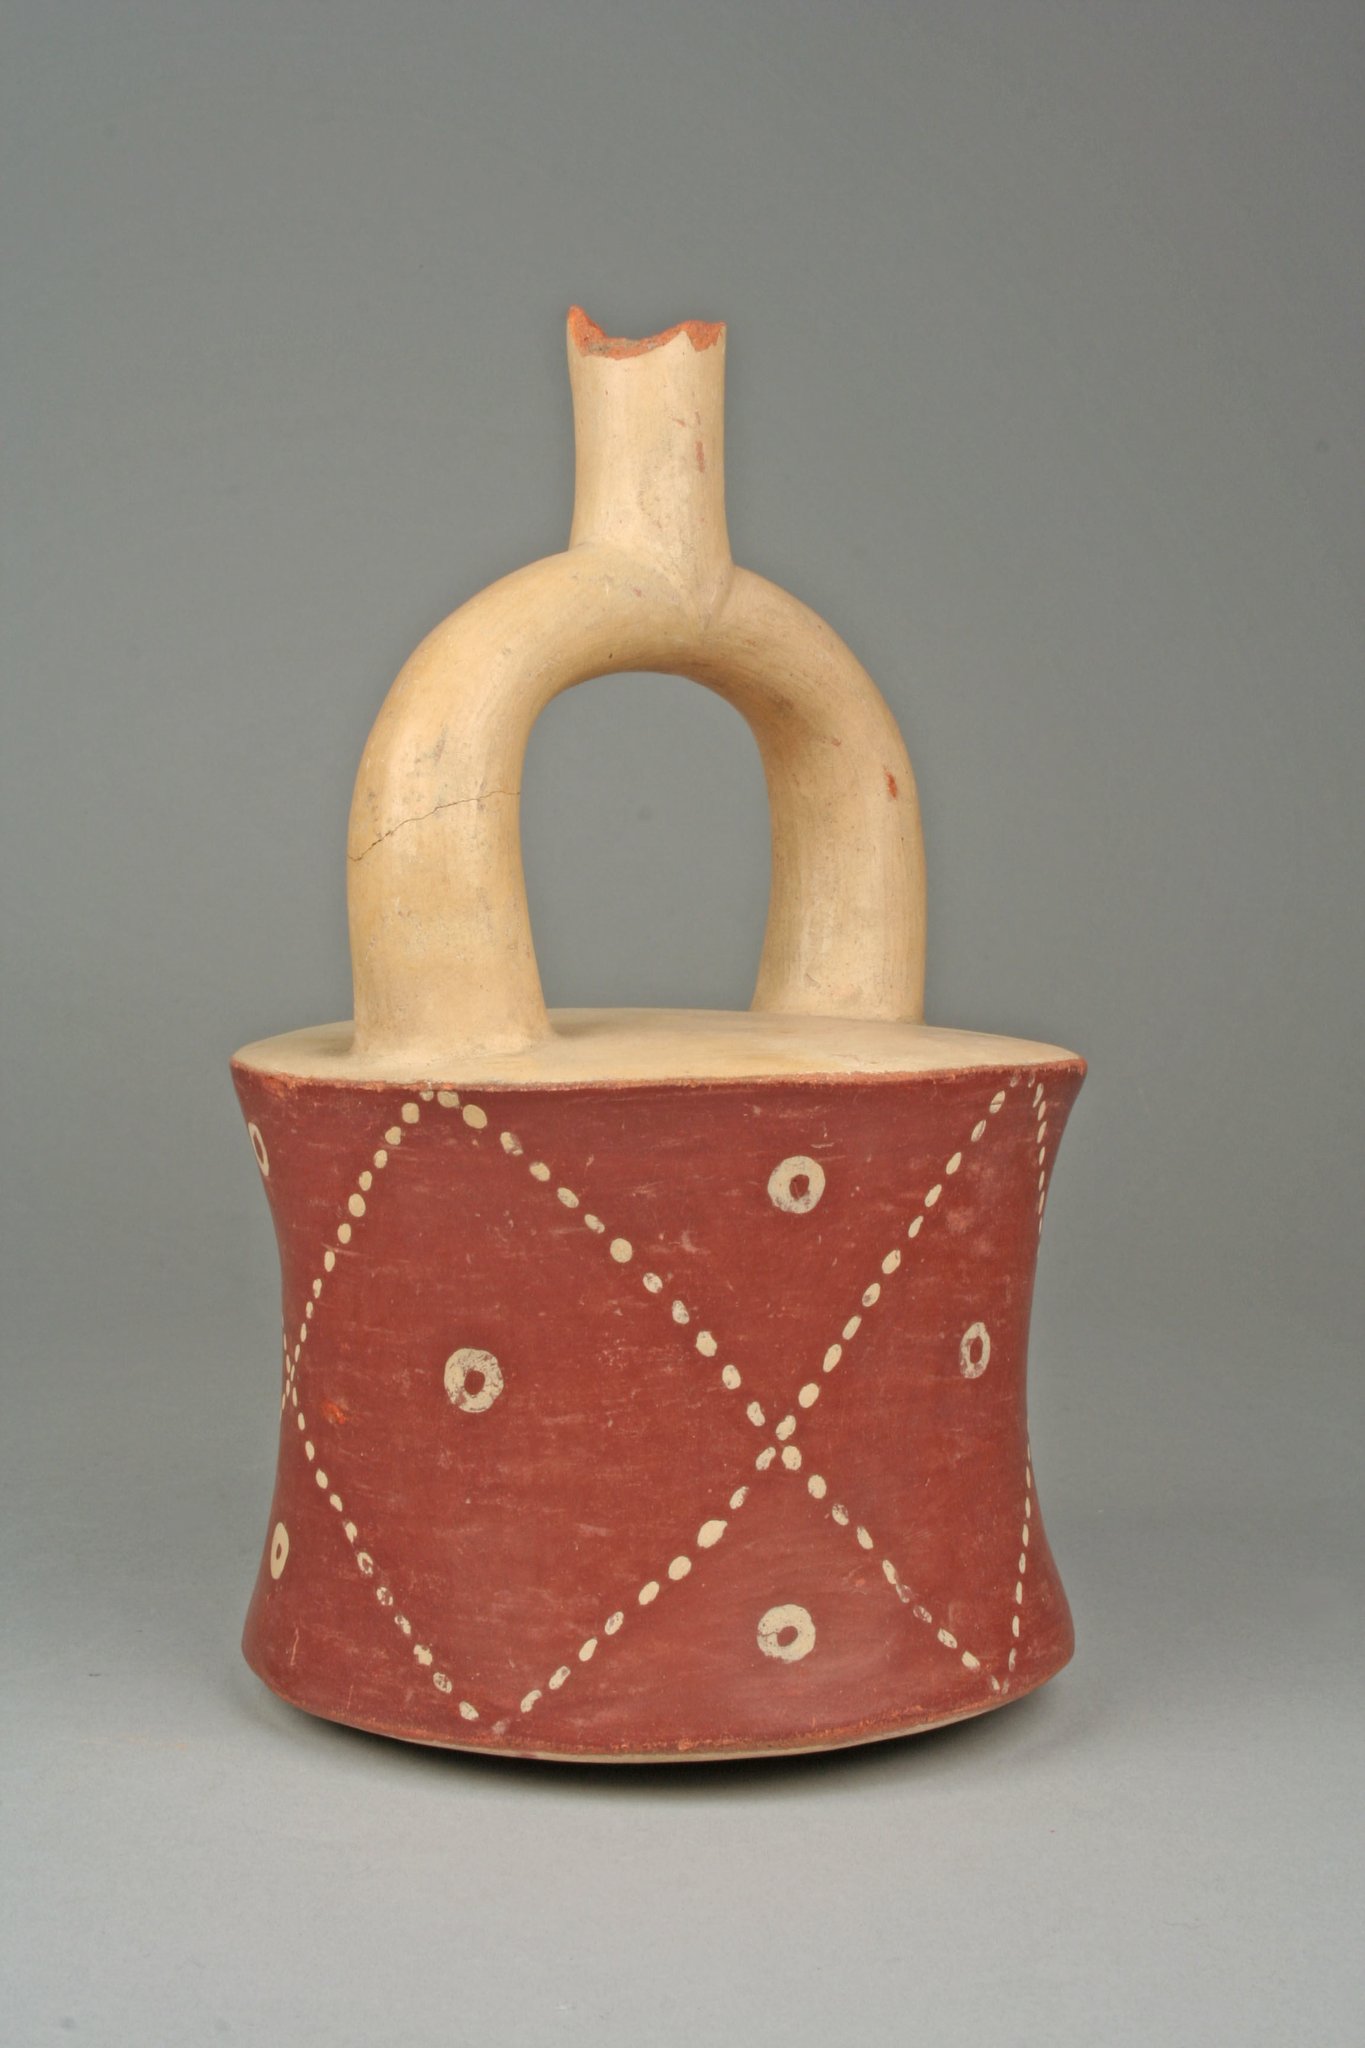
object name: bottle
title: Stirrup Spout Bottle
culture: moche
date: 301-600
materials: ceramic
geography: peru